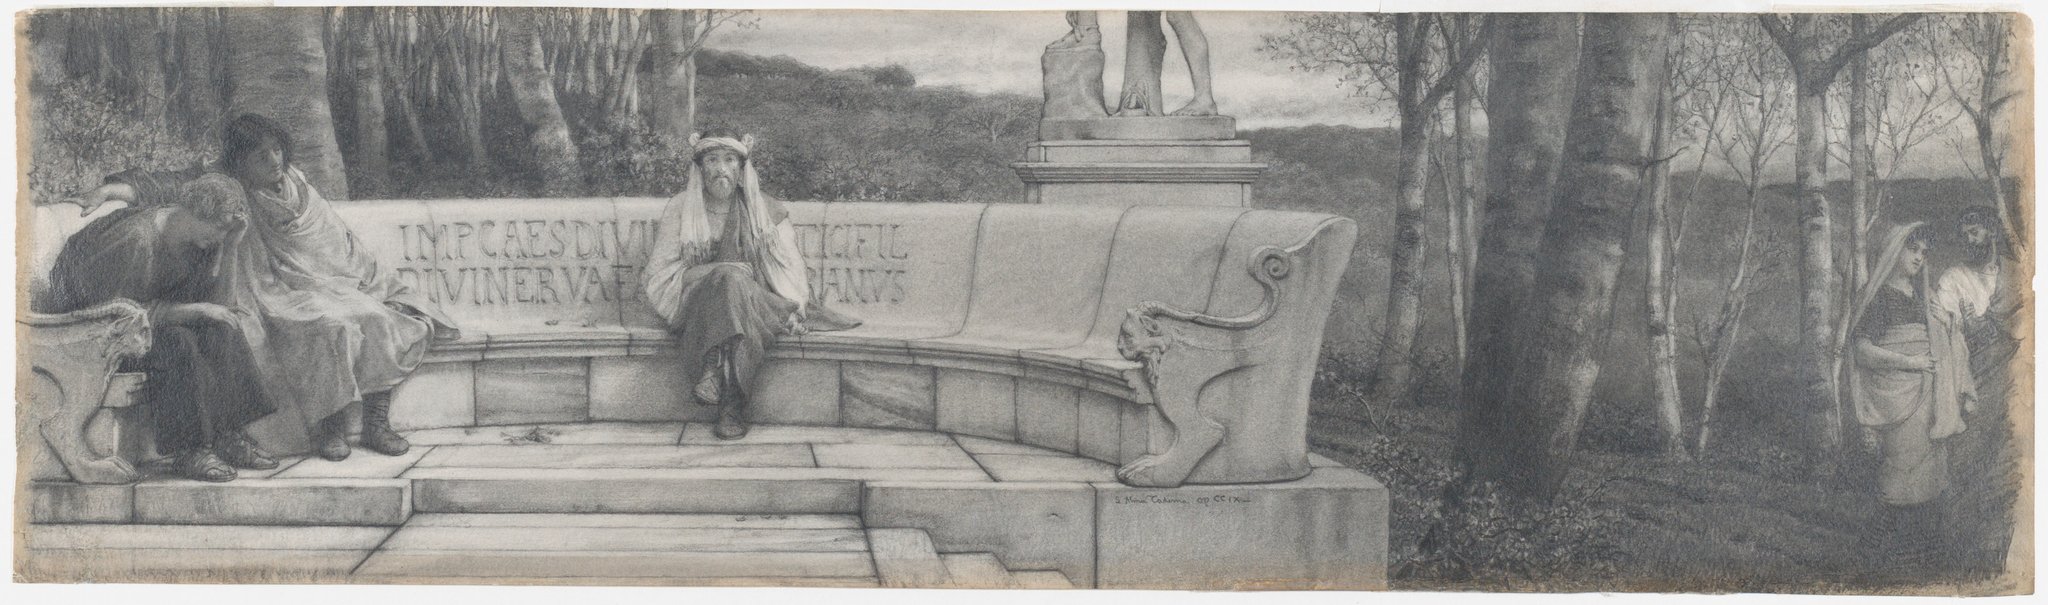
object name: drawing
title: Autumn (Scene in a Roman Garden)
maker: sir lawrence alma-tadema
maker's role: artist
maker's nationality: british, born the netherlands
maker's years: 1836-1912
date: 1874-1879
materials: graphite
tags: men,women,benches